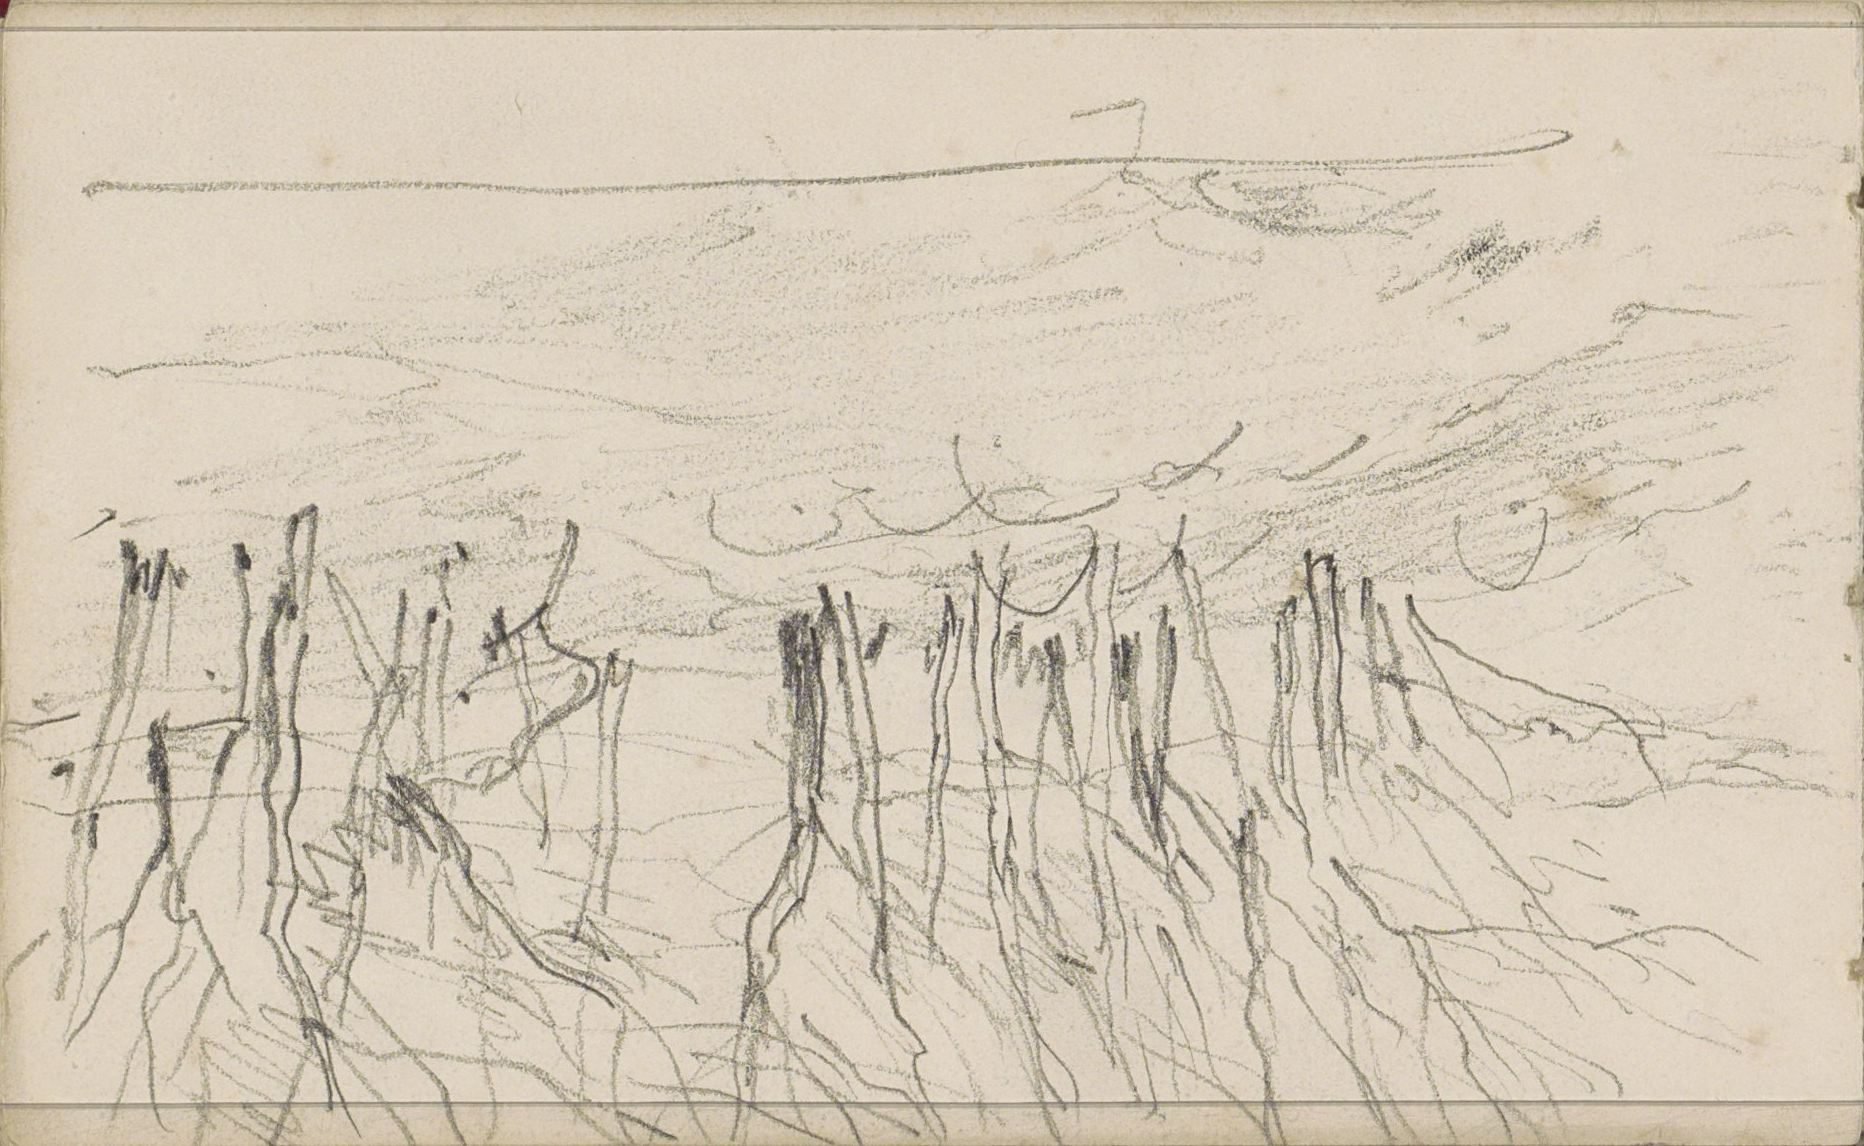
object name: sketchbook leaf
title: Bomengroep in een landschap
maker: anton mauve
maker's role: draughtsman, painter, print maker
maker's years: 1838-1888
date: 1876-1888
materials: paper, pencil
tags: trees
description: Blad 31 verso uit een schetsboek met 34 bladen.